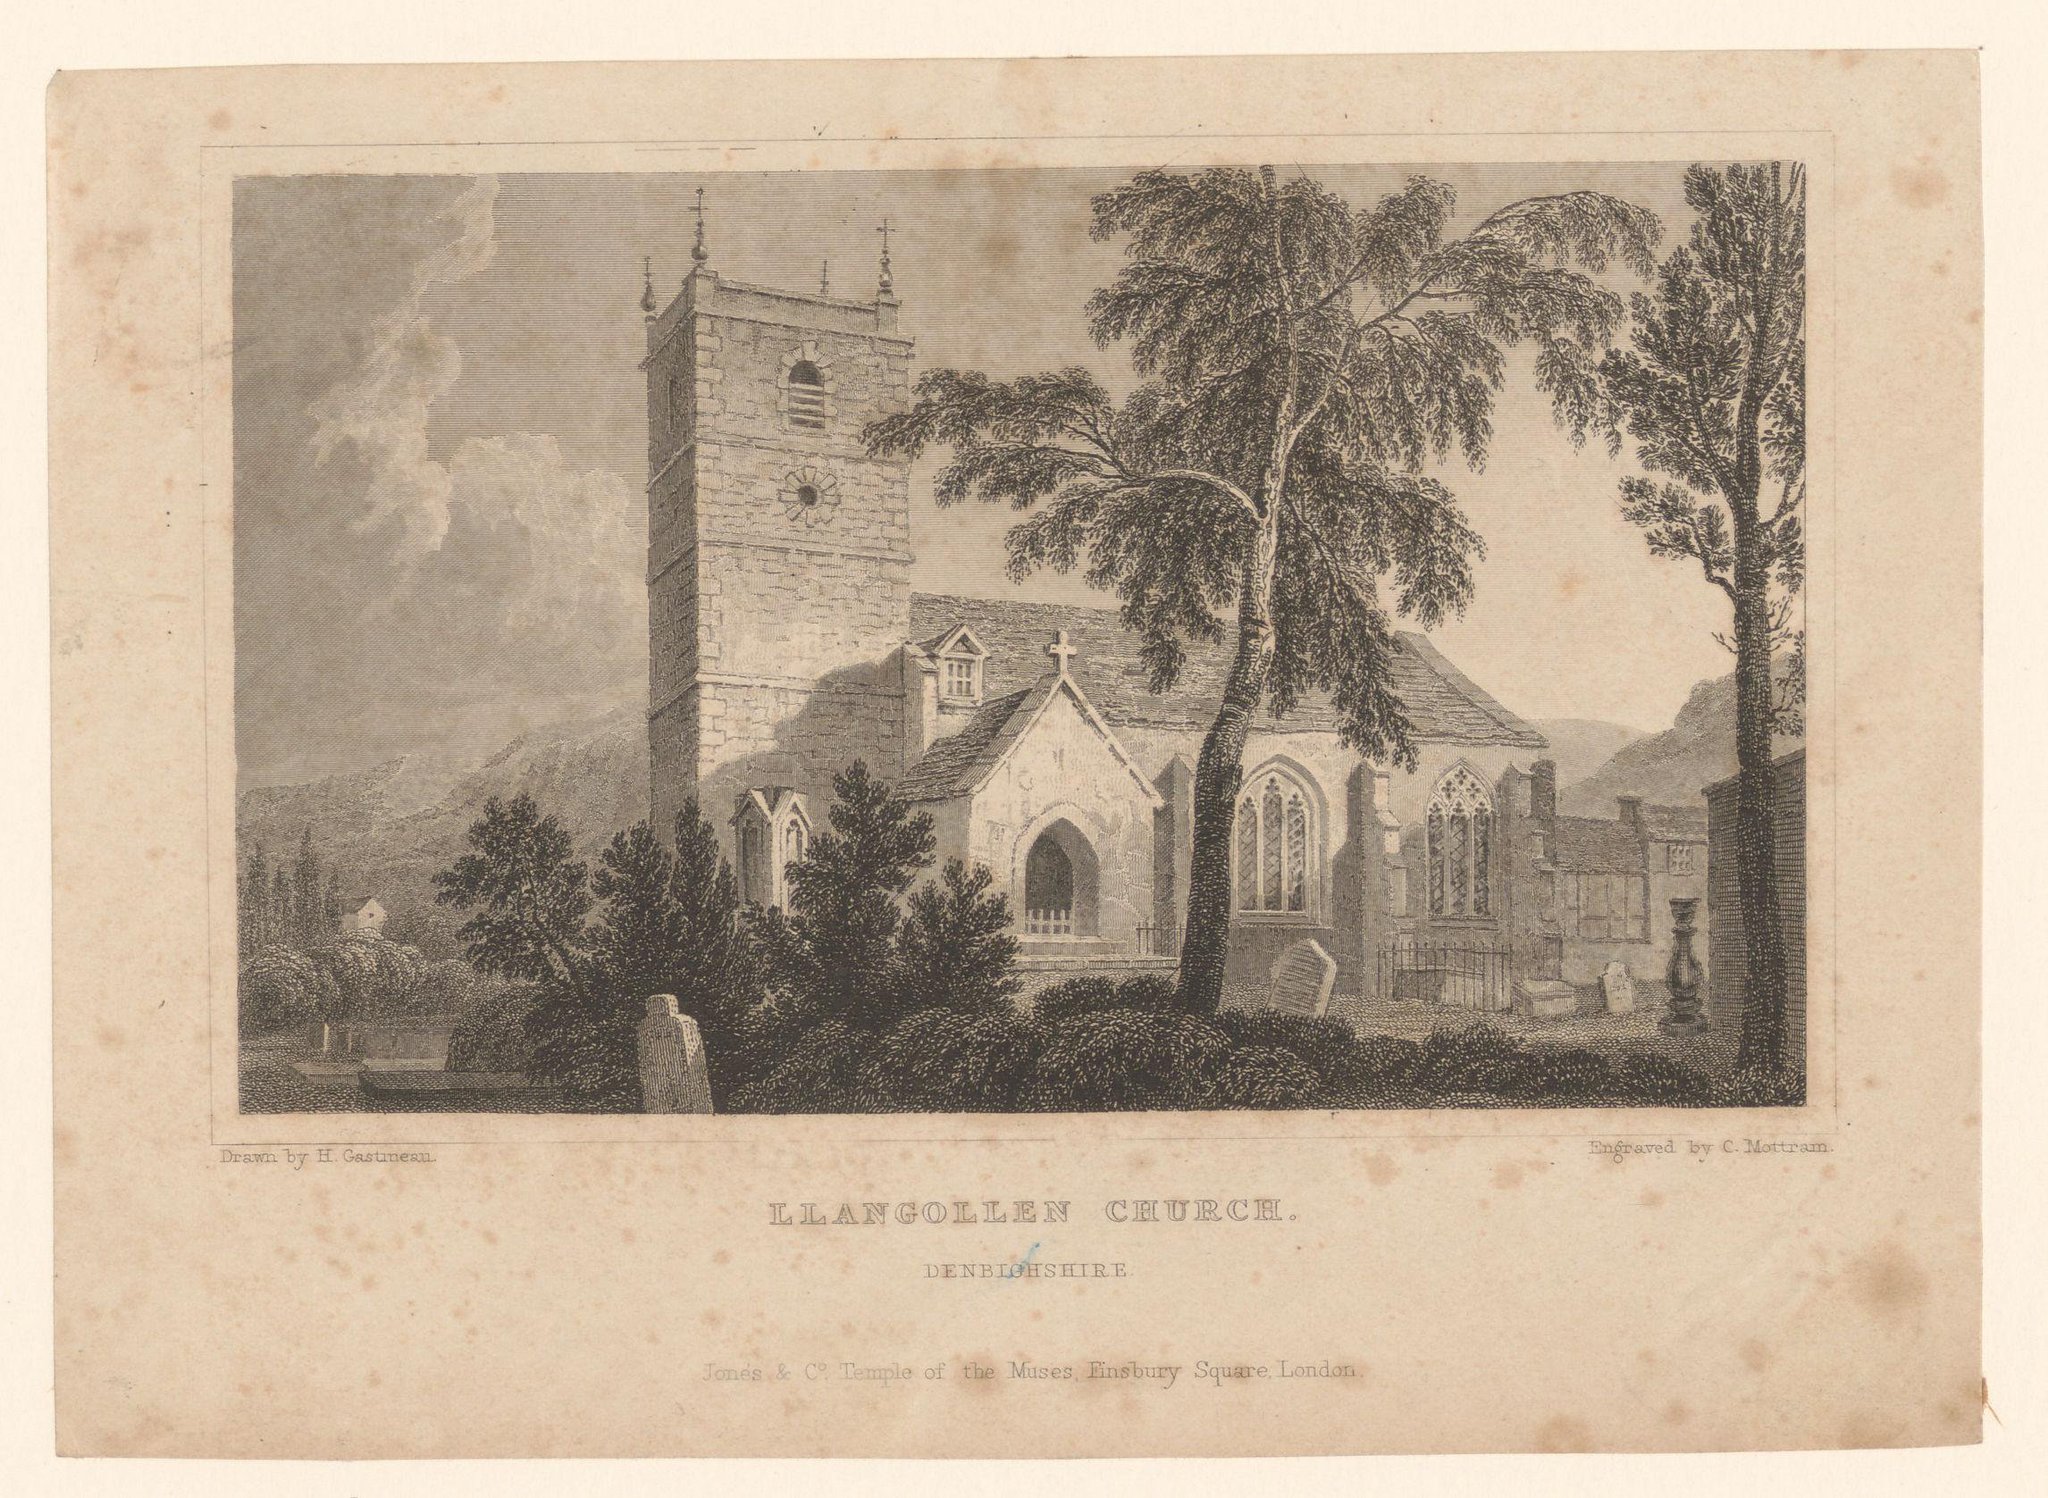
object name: print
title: Llangollen Church, Denbighshire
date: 1830-1850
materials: paper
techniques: etching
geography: england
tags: church (exterior)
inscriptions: collector's mark: Lugt 2228